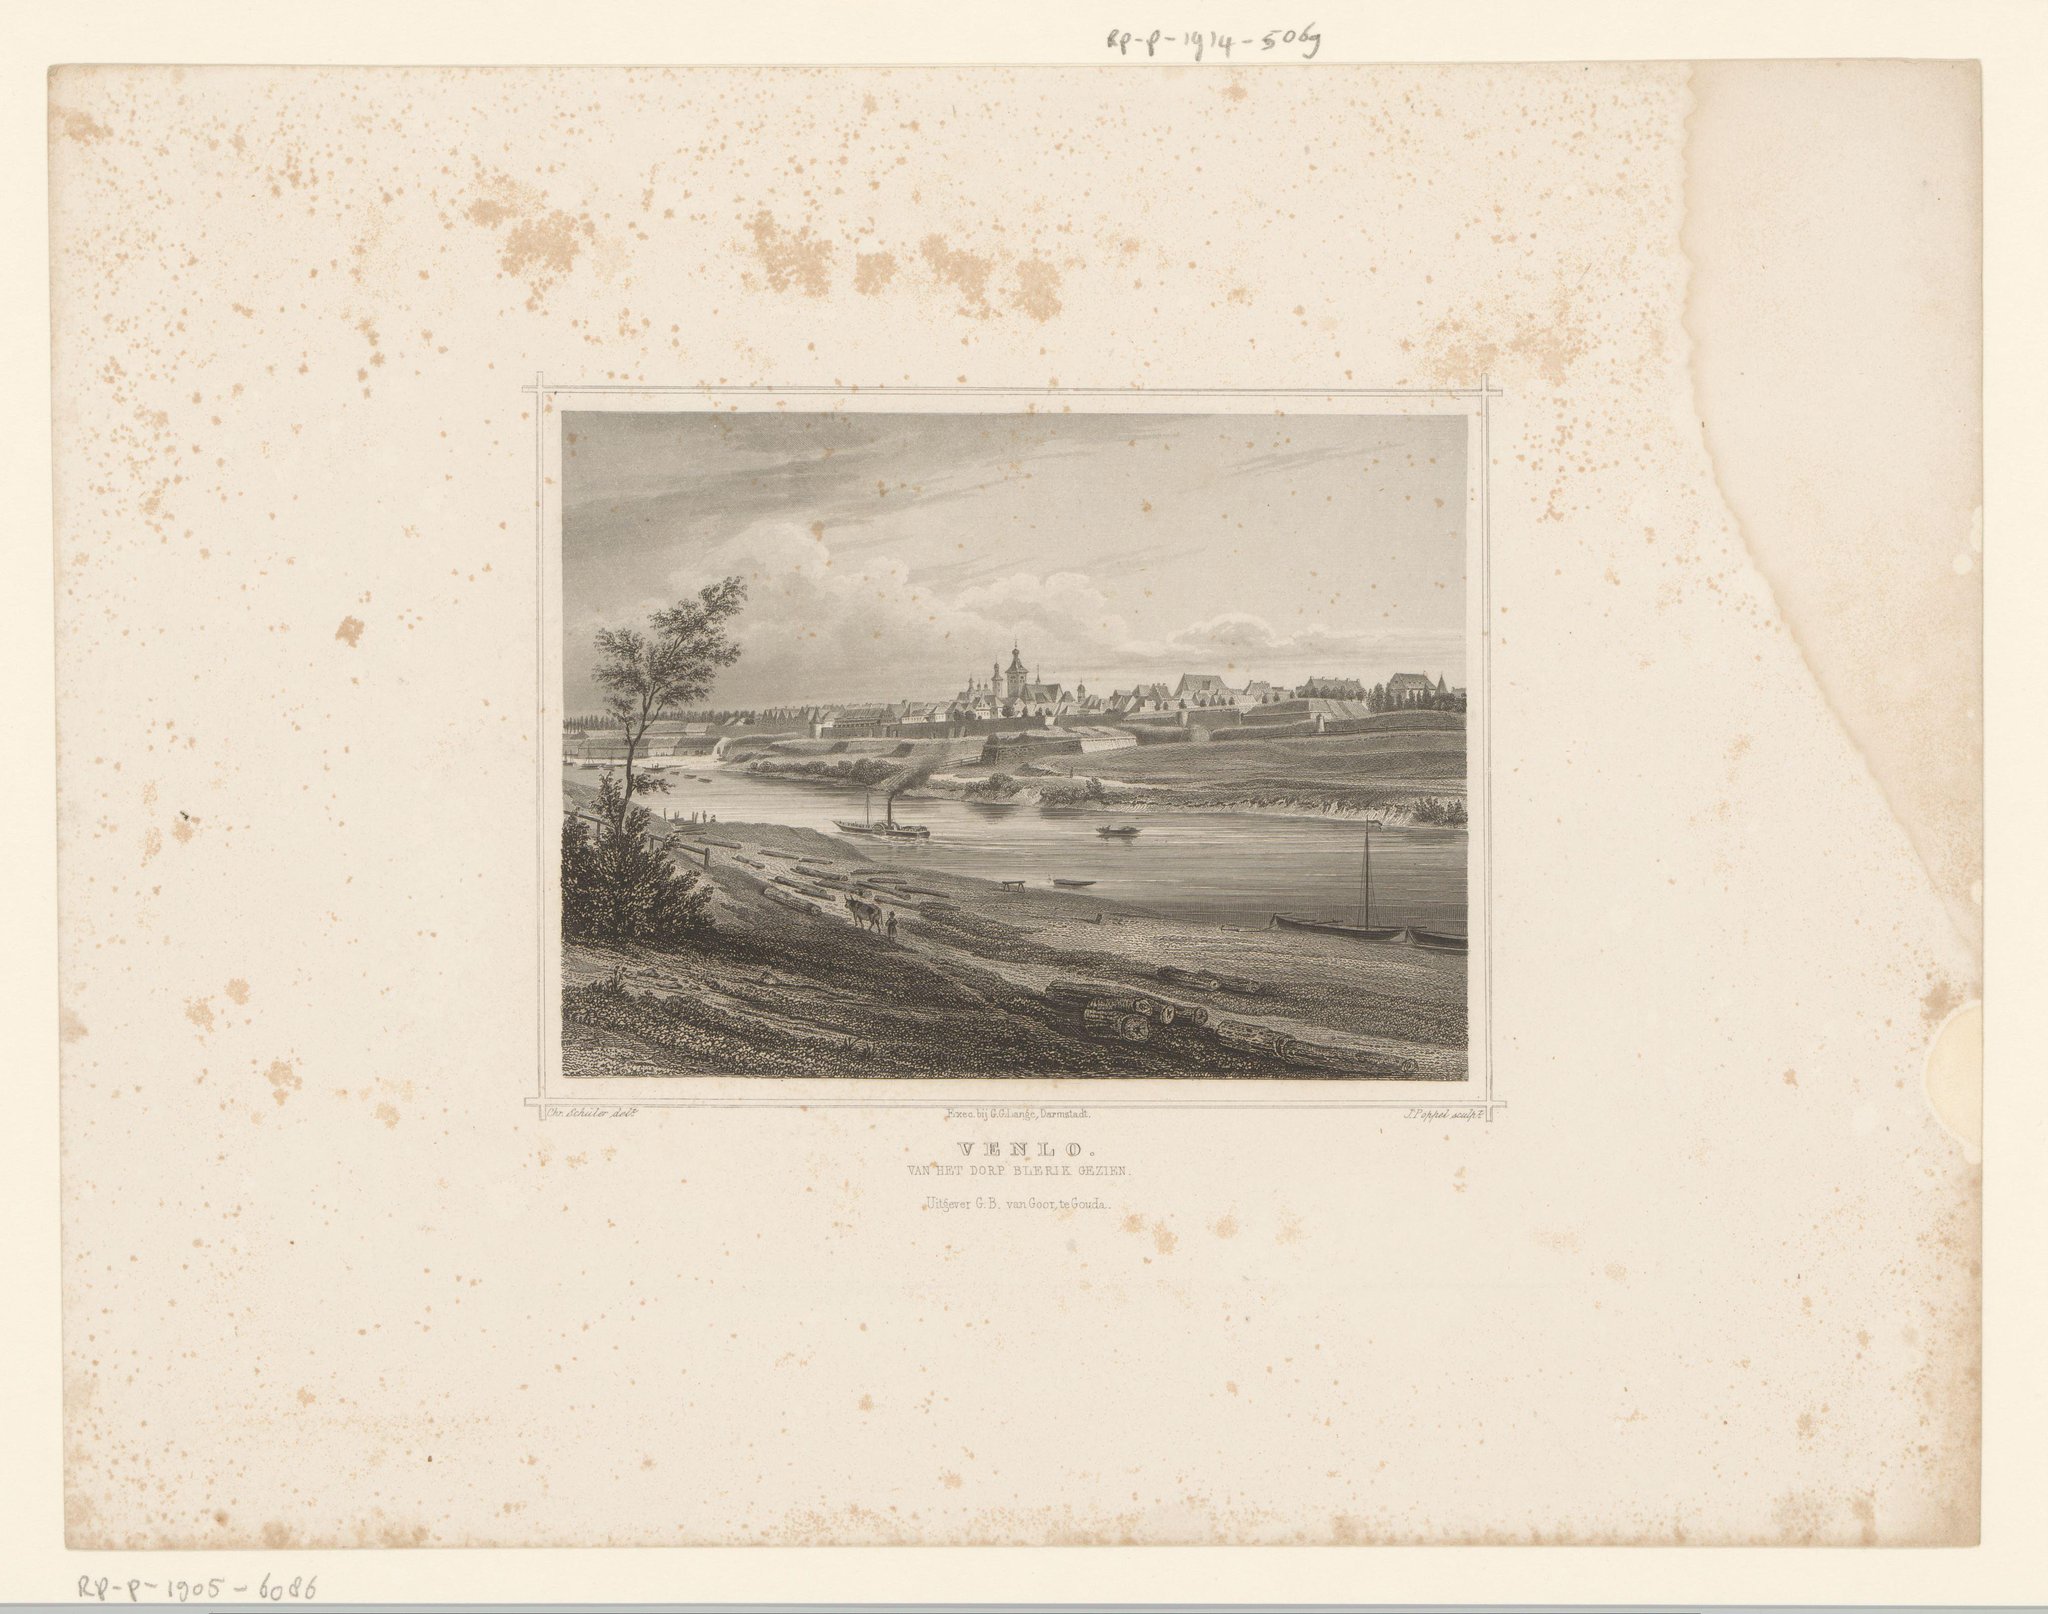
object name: print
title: Gezicht op Venlo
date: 1858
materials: paper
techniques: engraving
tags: city-view, and landscape with man-made constructions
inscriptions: collector's mark: Lugt 2228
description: Prent ook gebruikt in: Terwen, Johannes Leonardus. Het Koningrijk der Nederlanden voorgesteld in eene reeks van naar de natuur geteekende schilderachtige gezigten. Gouda: Van Goor, 1858-1862.